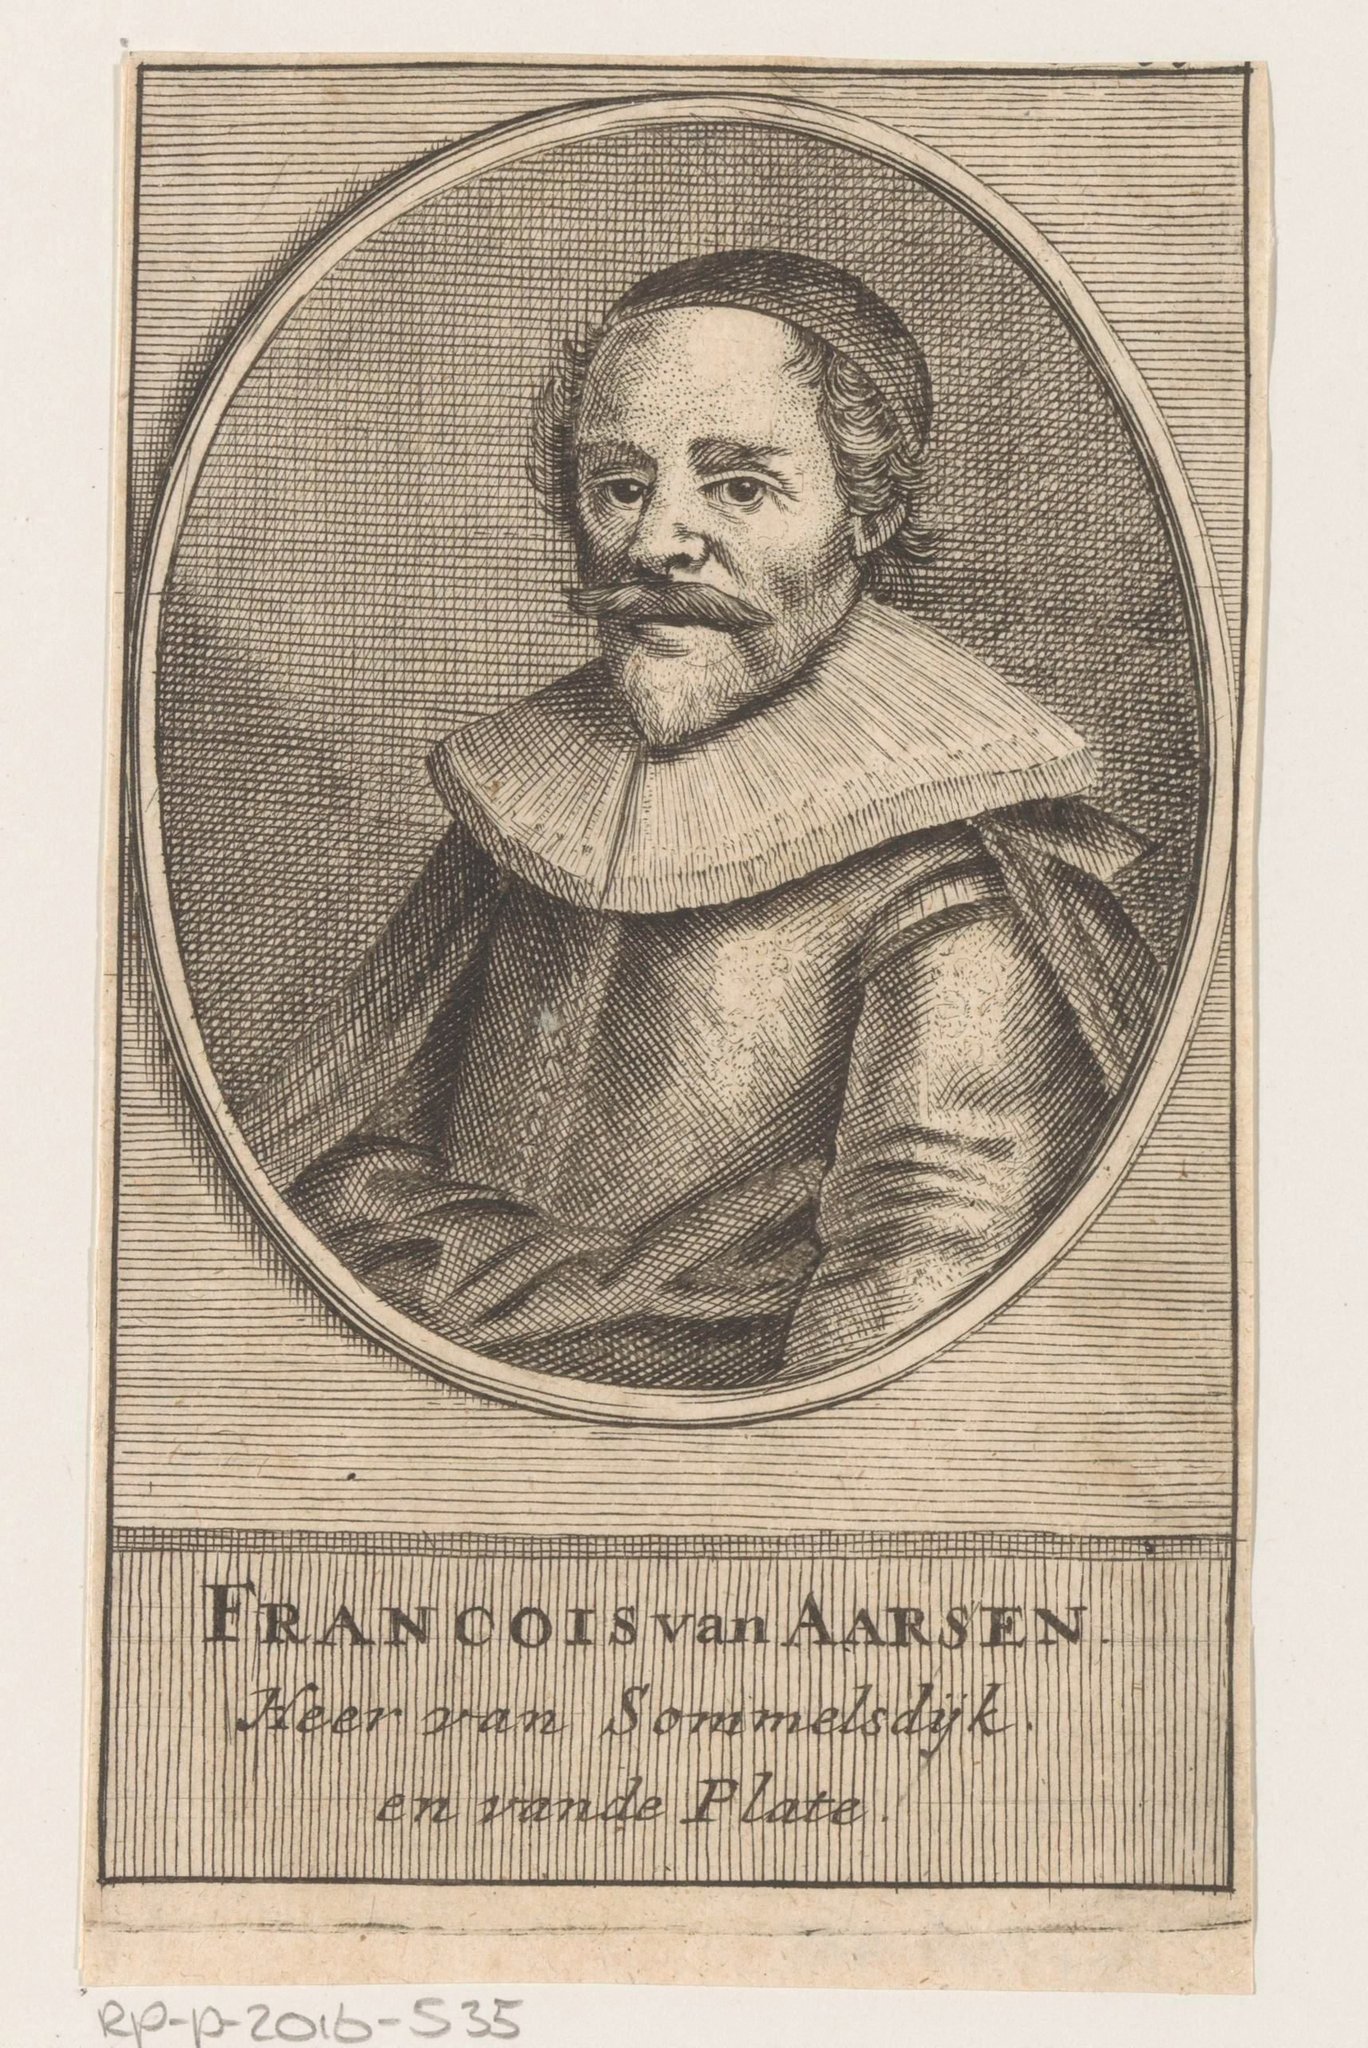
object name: print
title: Portret van François van Aerssen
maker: Anonymous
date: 1612-1699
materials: paper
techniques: engraving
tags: brussels, the hague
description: Portret van François van Aerssen in een ovale omlijsting. In een kader zijn naam en titels.